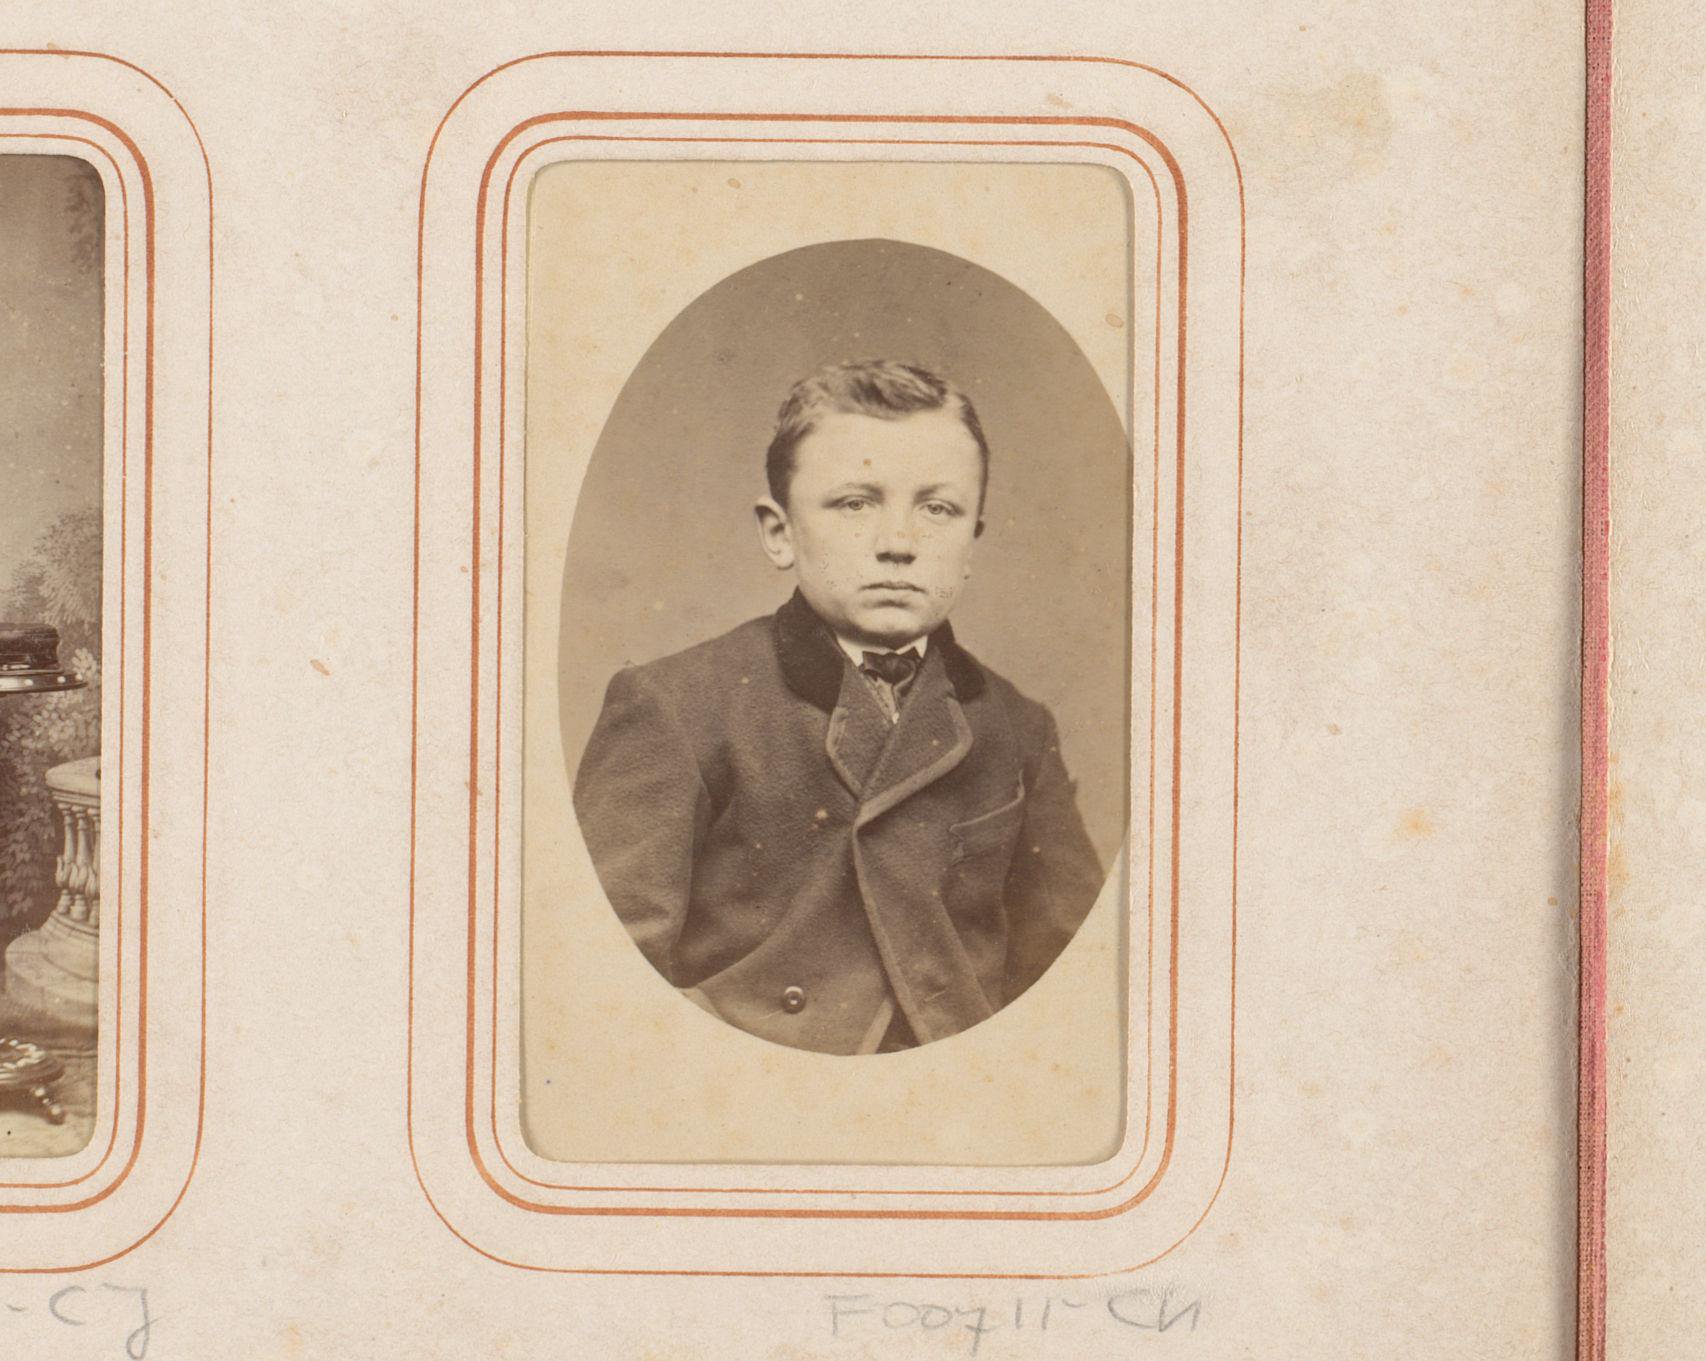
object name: photograph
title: Portret van een jongen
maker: benjamin van der heide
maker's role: fotograaf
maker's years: 1837-1928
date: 1871-1900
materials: cardboard, photographic support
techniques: albumen print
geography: harlingen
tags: boy (child between toddler and youth)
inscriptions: inscription: ‘Photographie van B. van der Heide/ Harlingen/ Bekroond op de tentoonstelling van Nijverheid te Harlingen 1871’